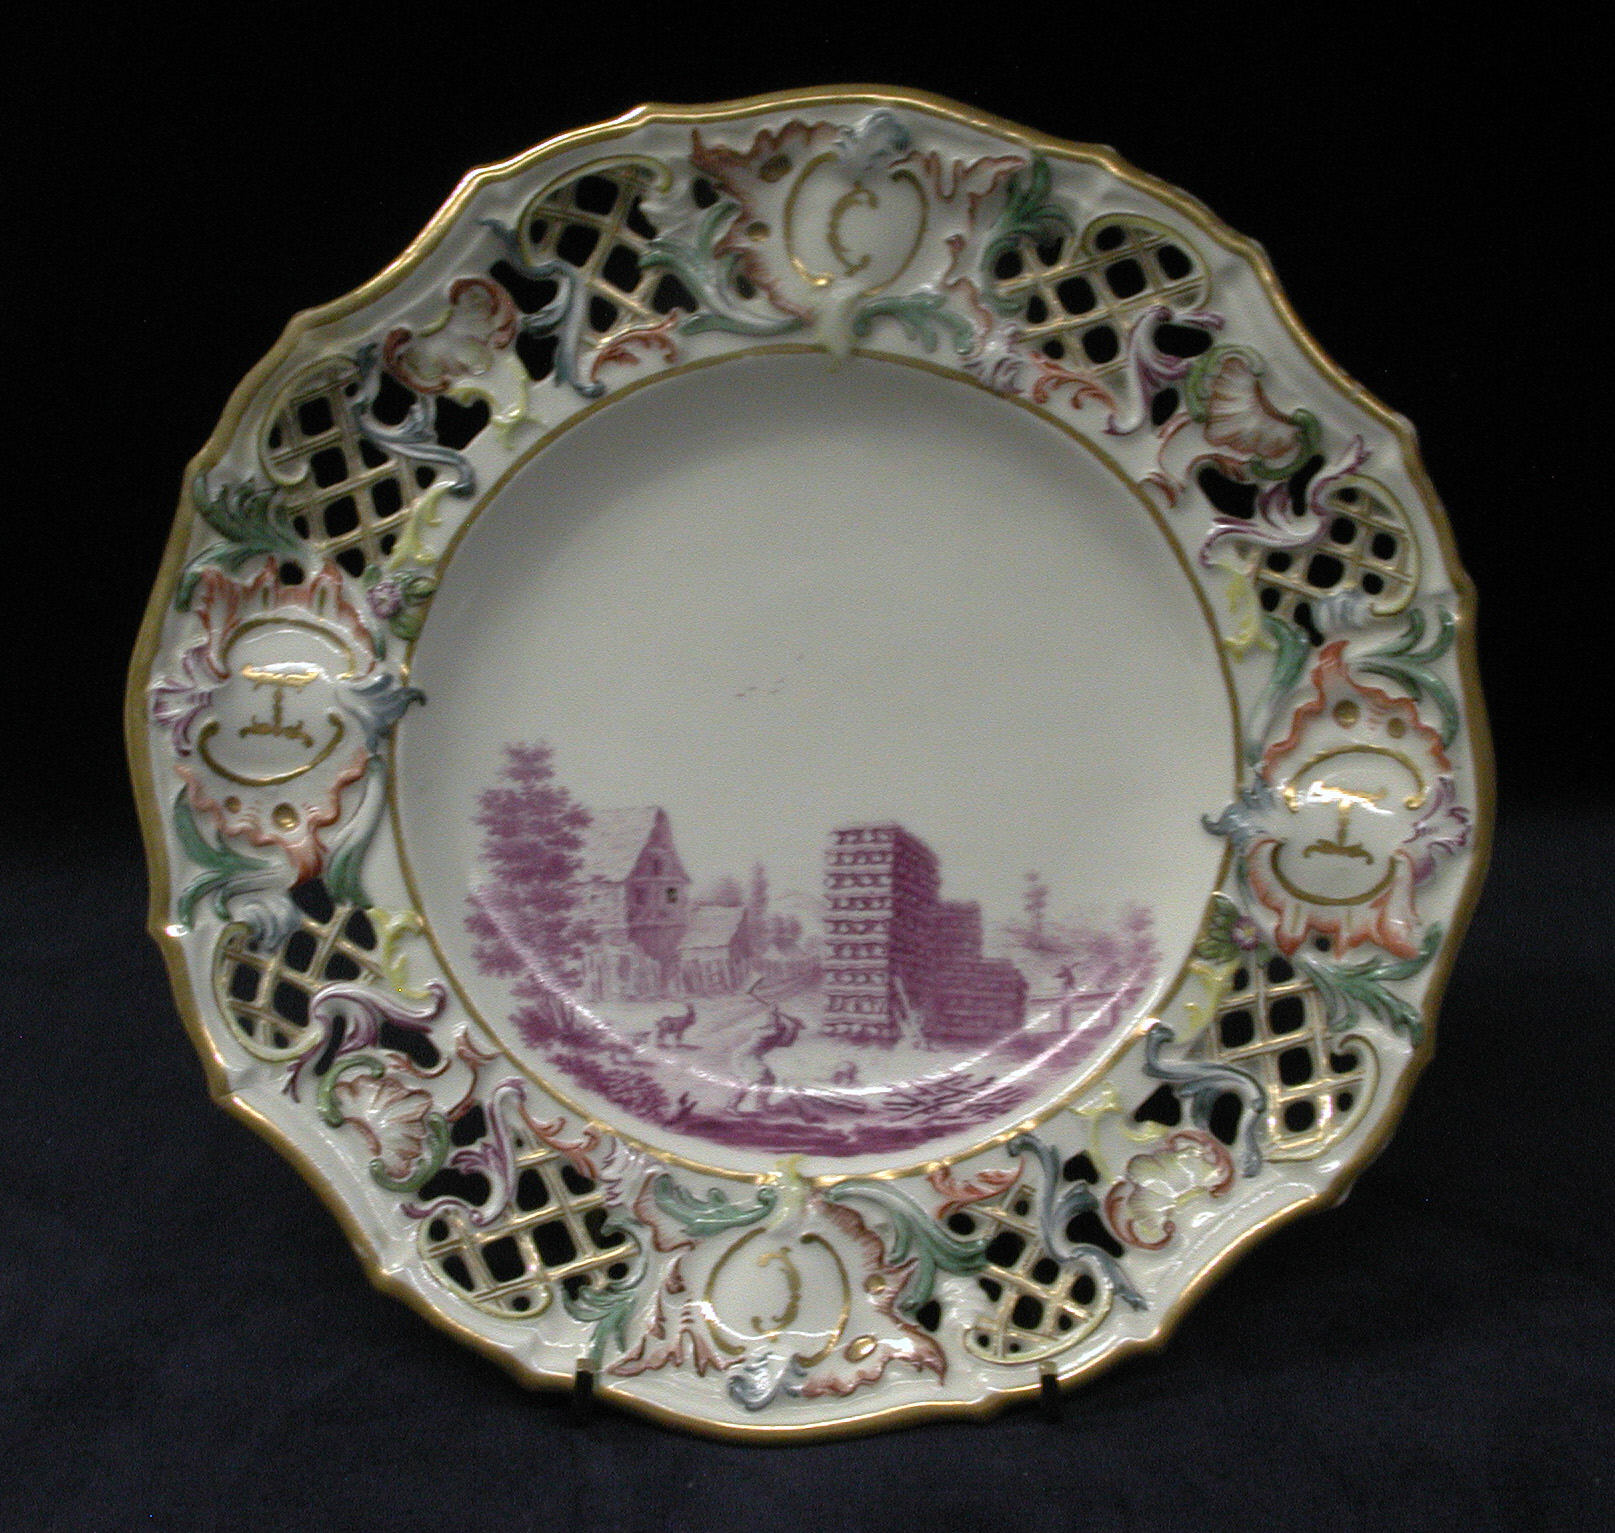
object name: dessert plate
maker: fürstenberg porcelain manufactory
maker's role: manufactory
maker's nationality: german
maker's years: 1747-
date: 1758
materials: hard paste porcelain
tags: houses,trees,working,insignia